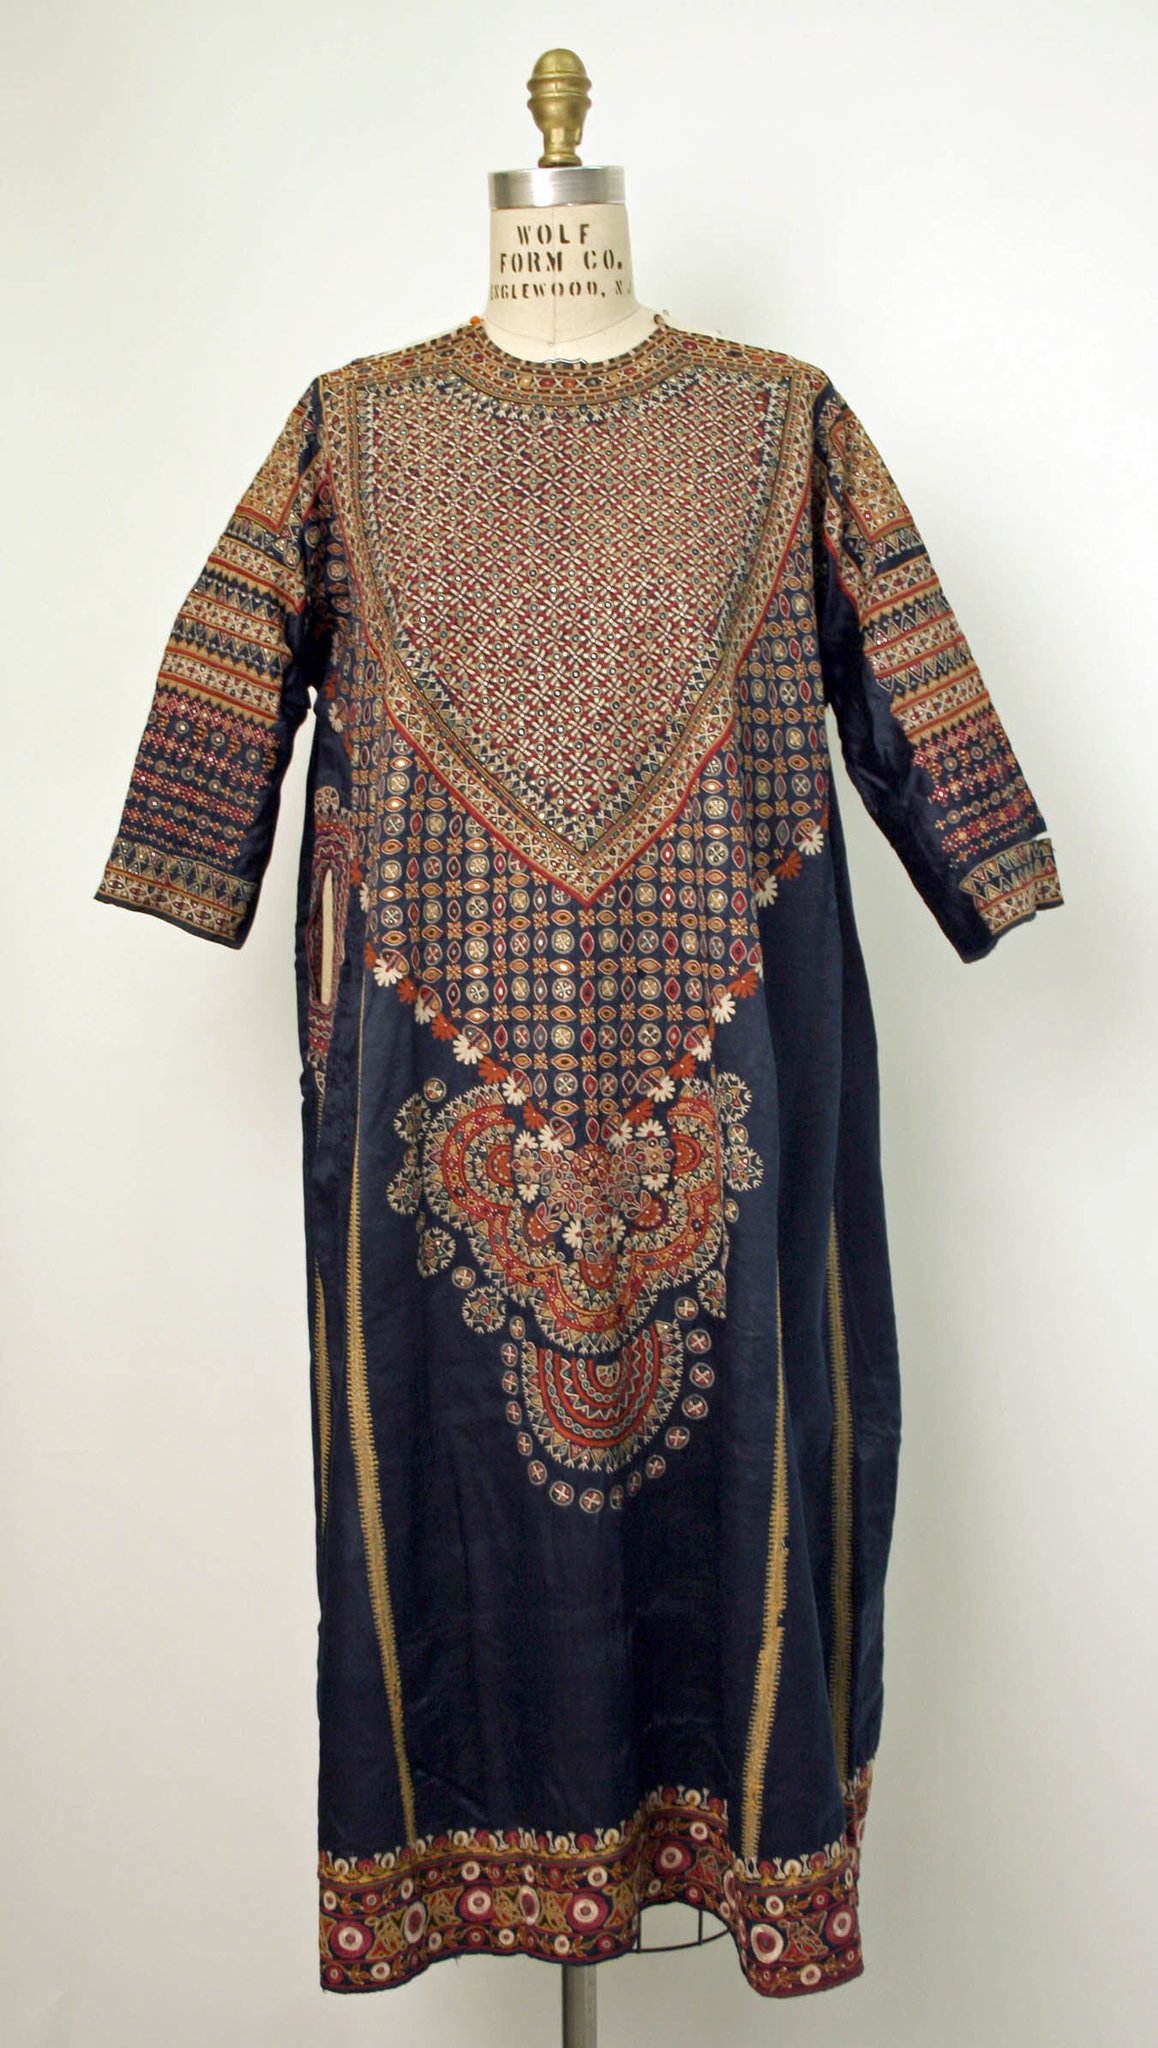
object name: dress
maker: liberty & co.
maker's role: department store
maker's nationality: british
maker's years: 1875-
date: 1767-1833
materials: textile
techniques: embroidery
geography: india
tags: dresses